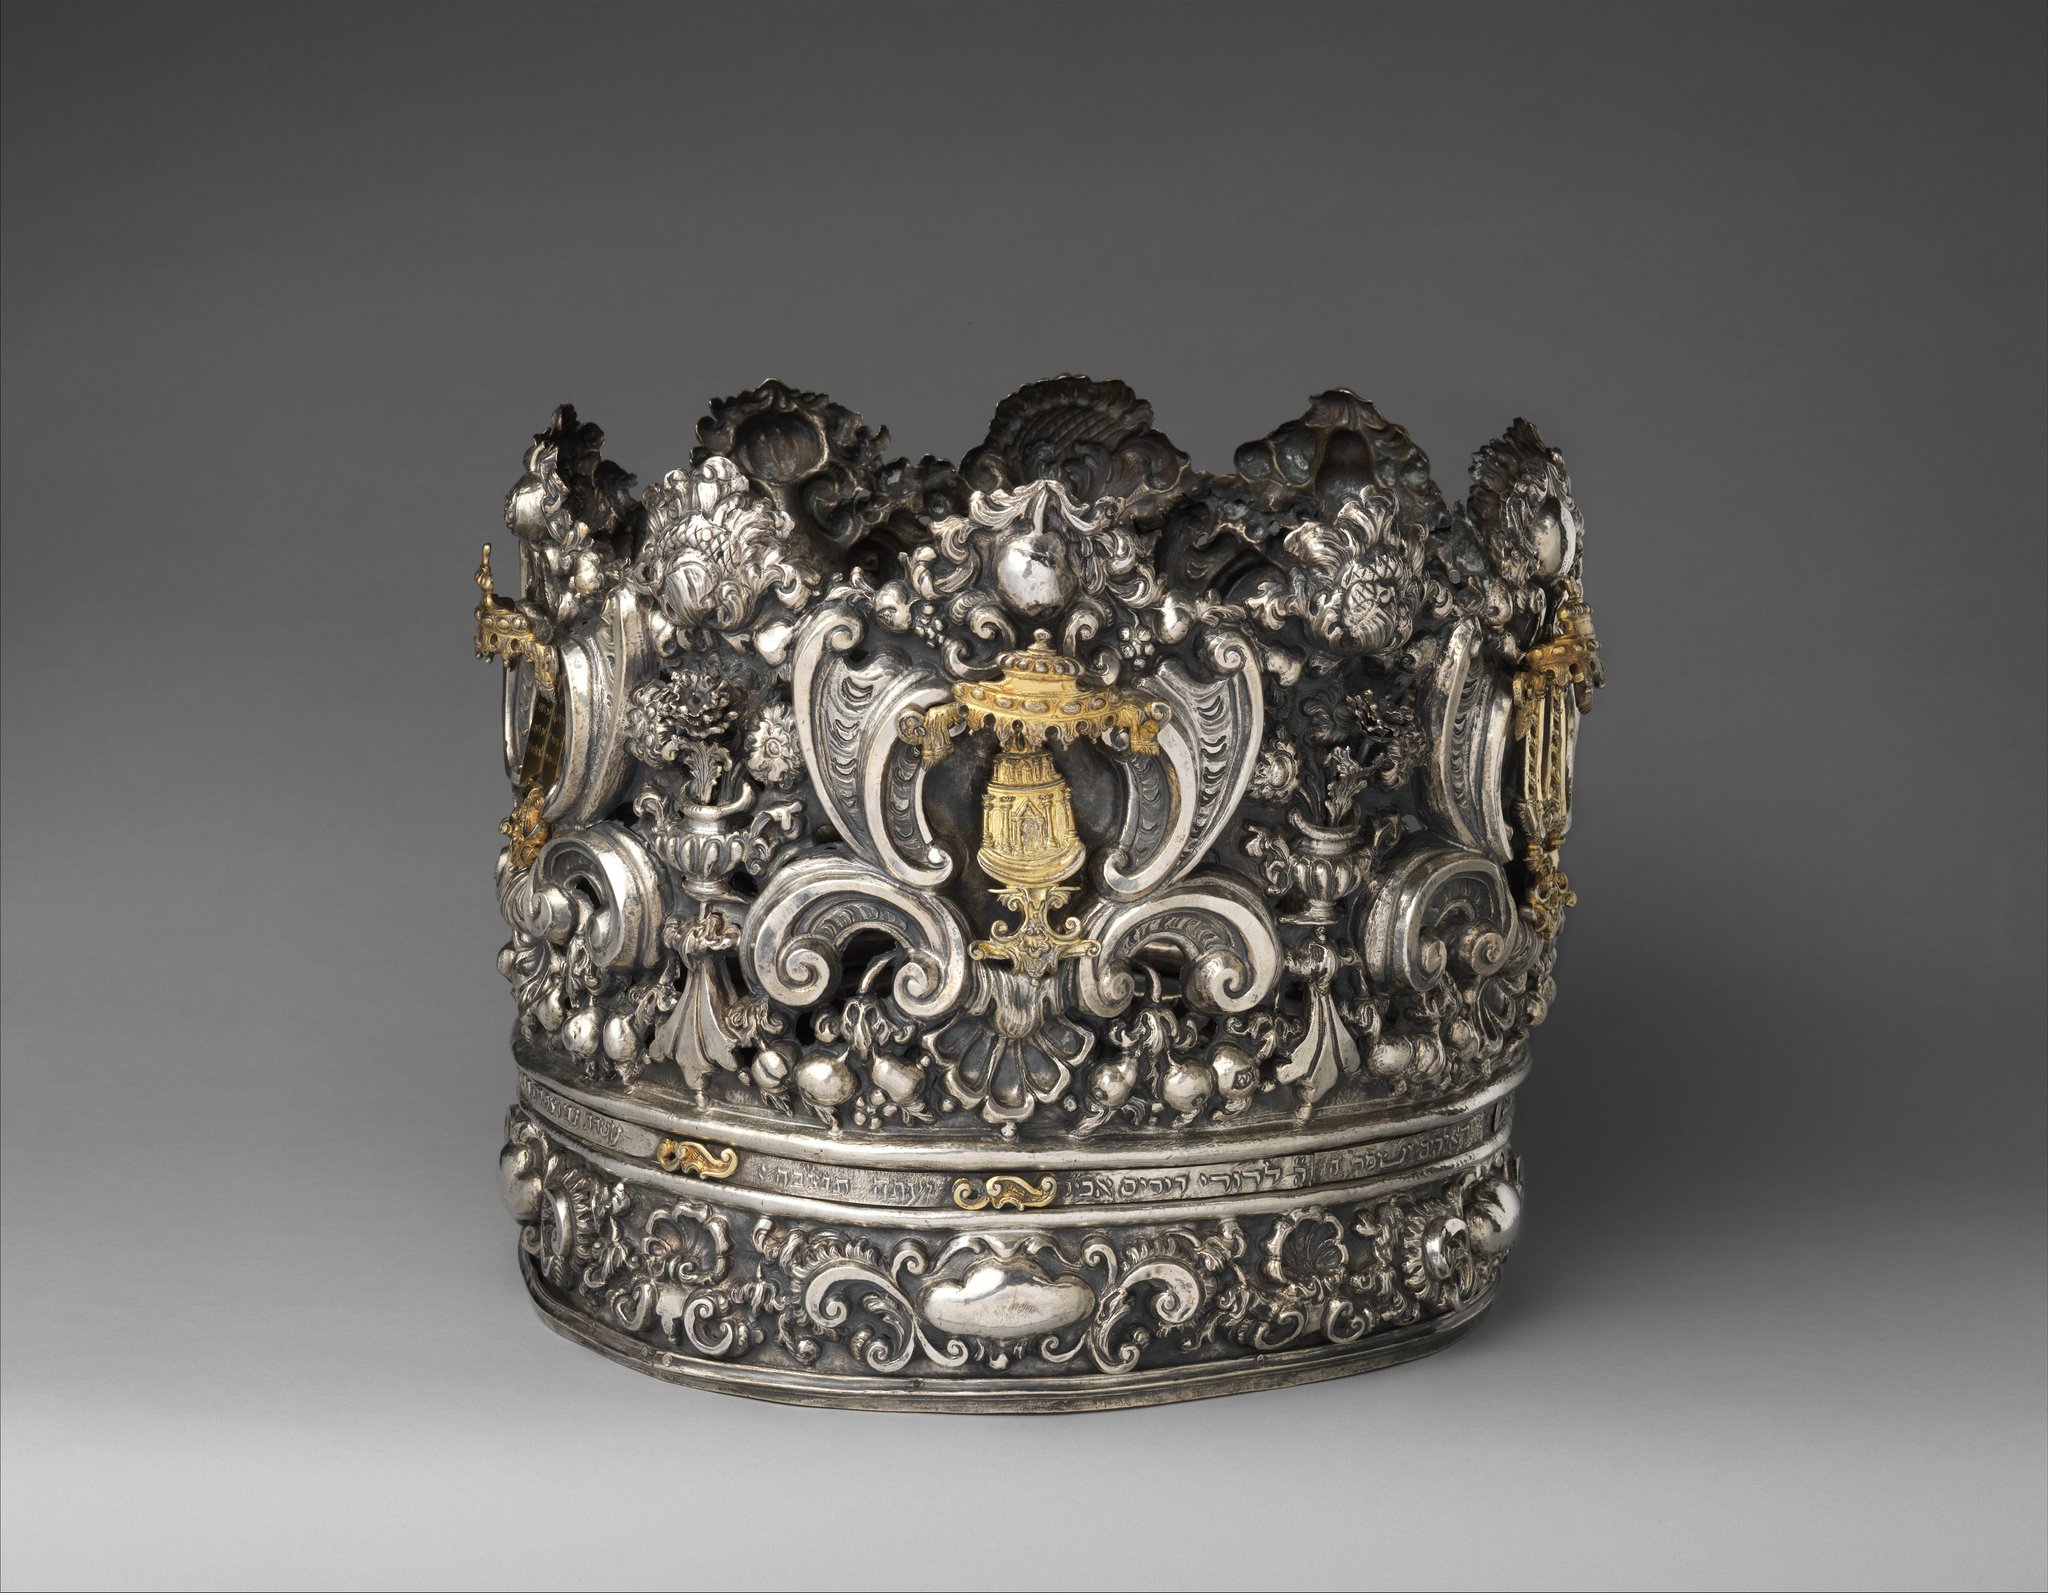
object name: torah crown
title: Torah crown (keter)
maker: andrea zambelli "l'honnesta"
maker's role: silversmith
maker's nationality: italian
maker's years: 1720-1772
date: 1740-1750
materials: gilt, silver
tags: crowns